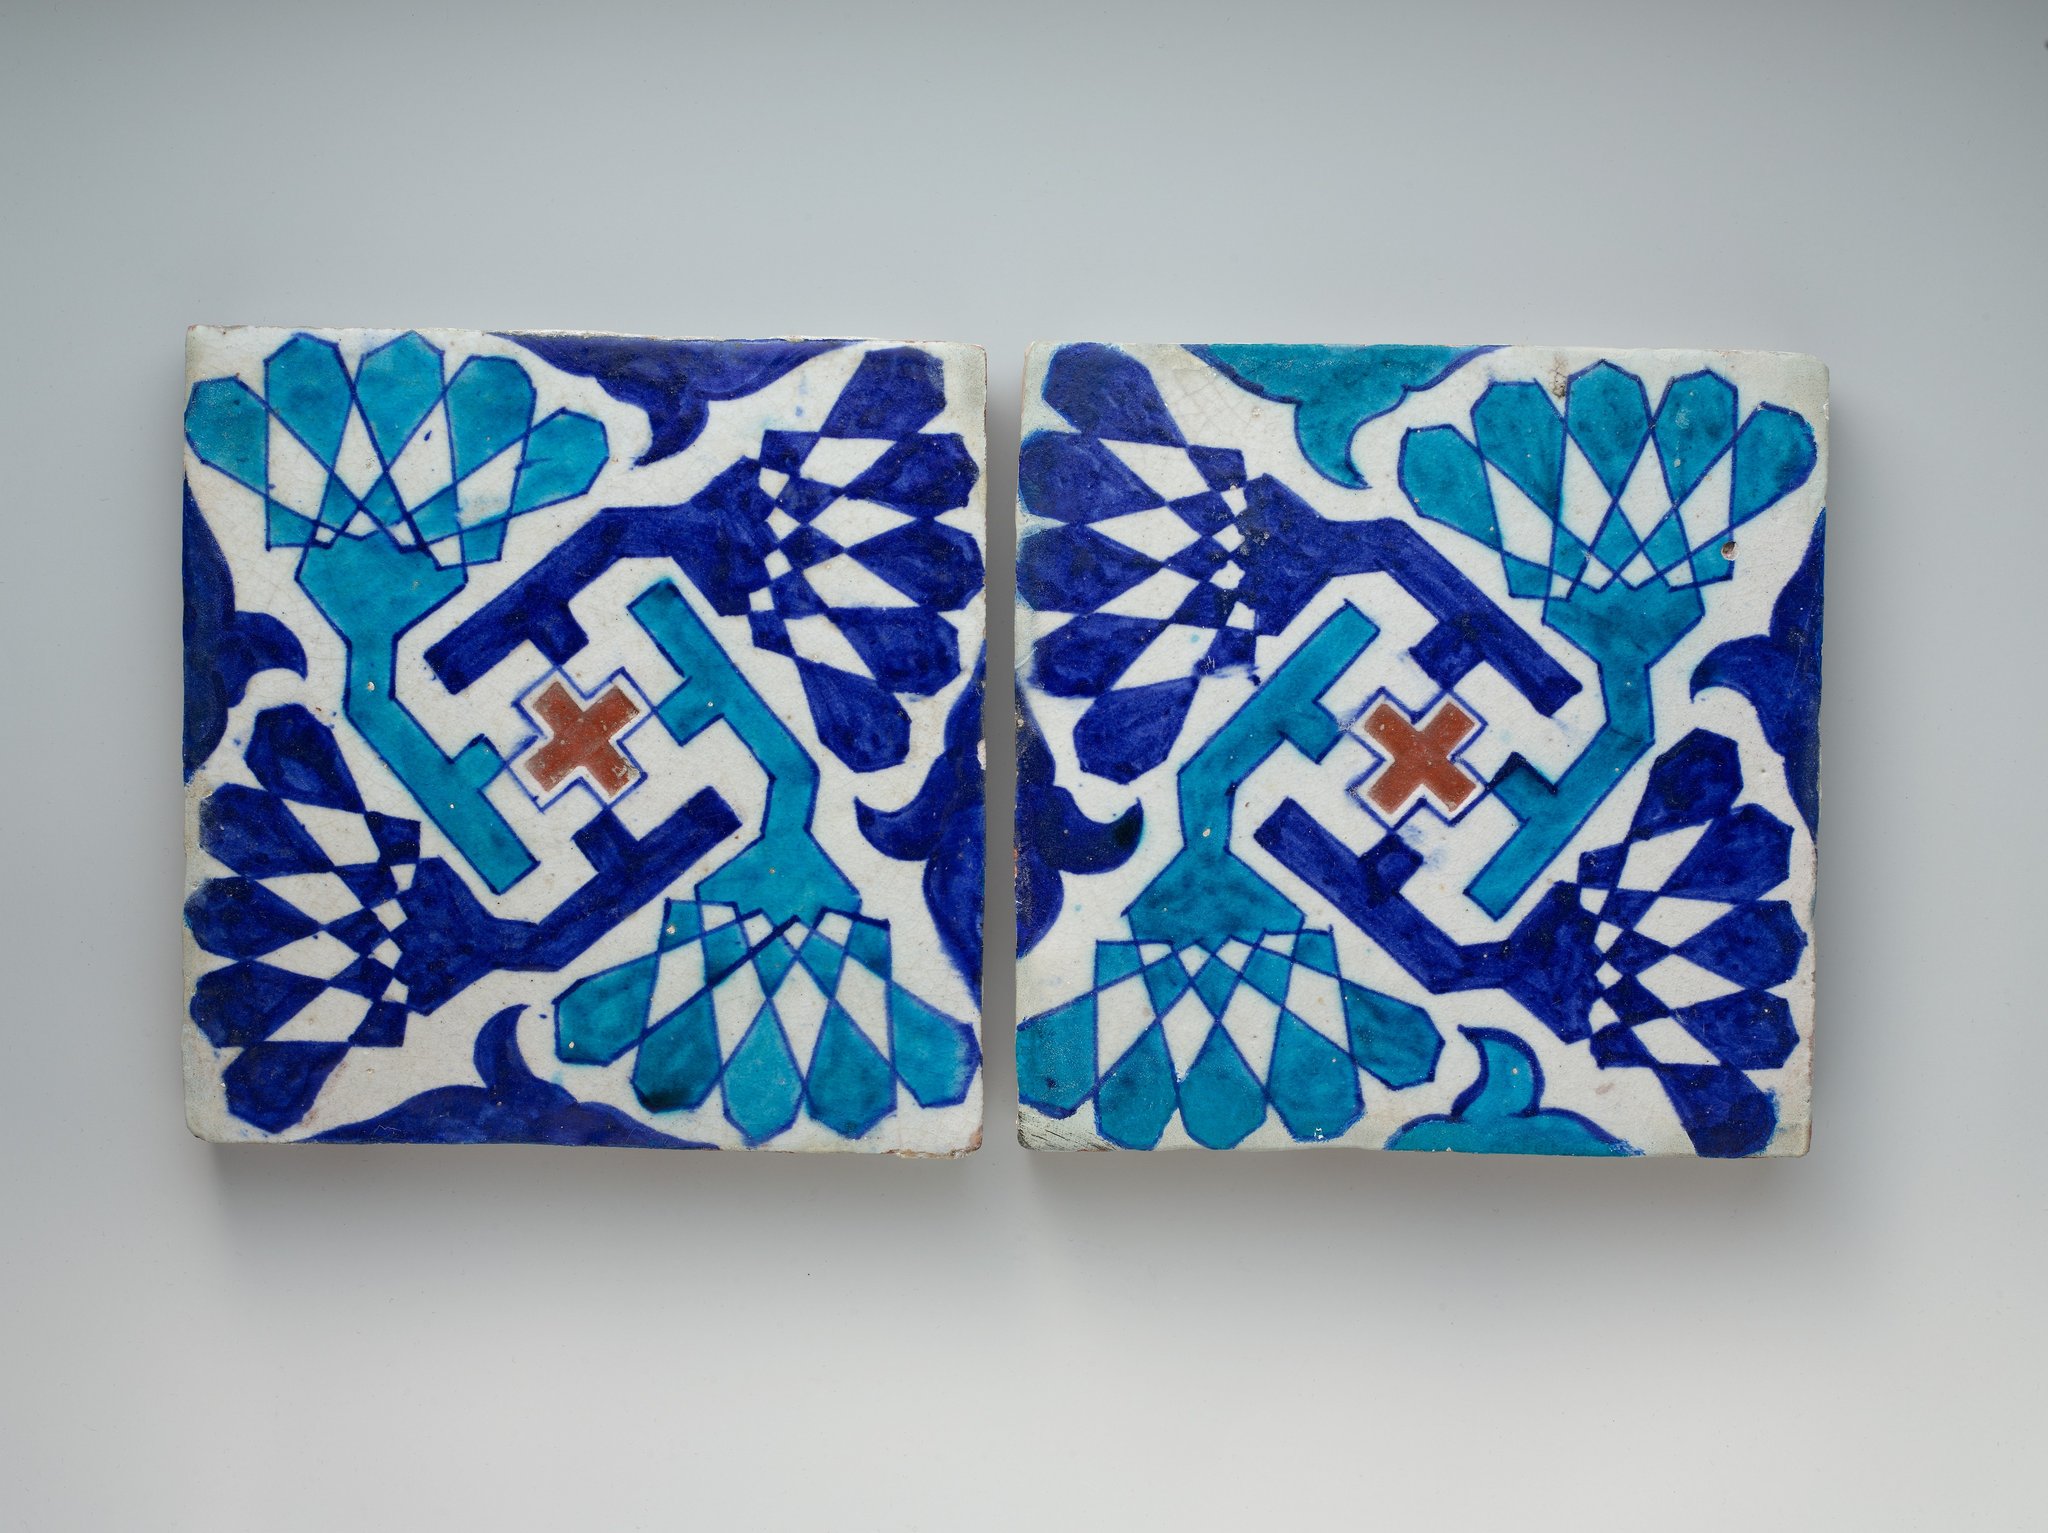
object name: tile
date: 1467-1500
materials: glaze, stonepaste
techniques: painting, polychrome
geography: pakistan